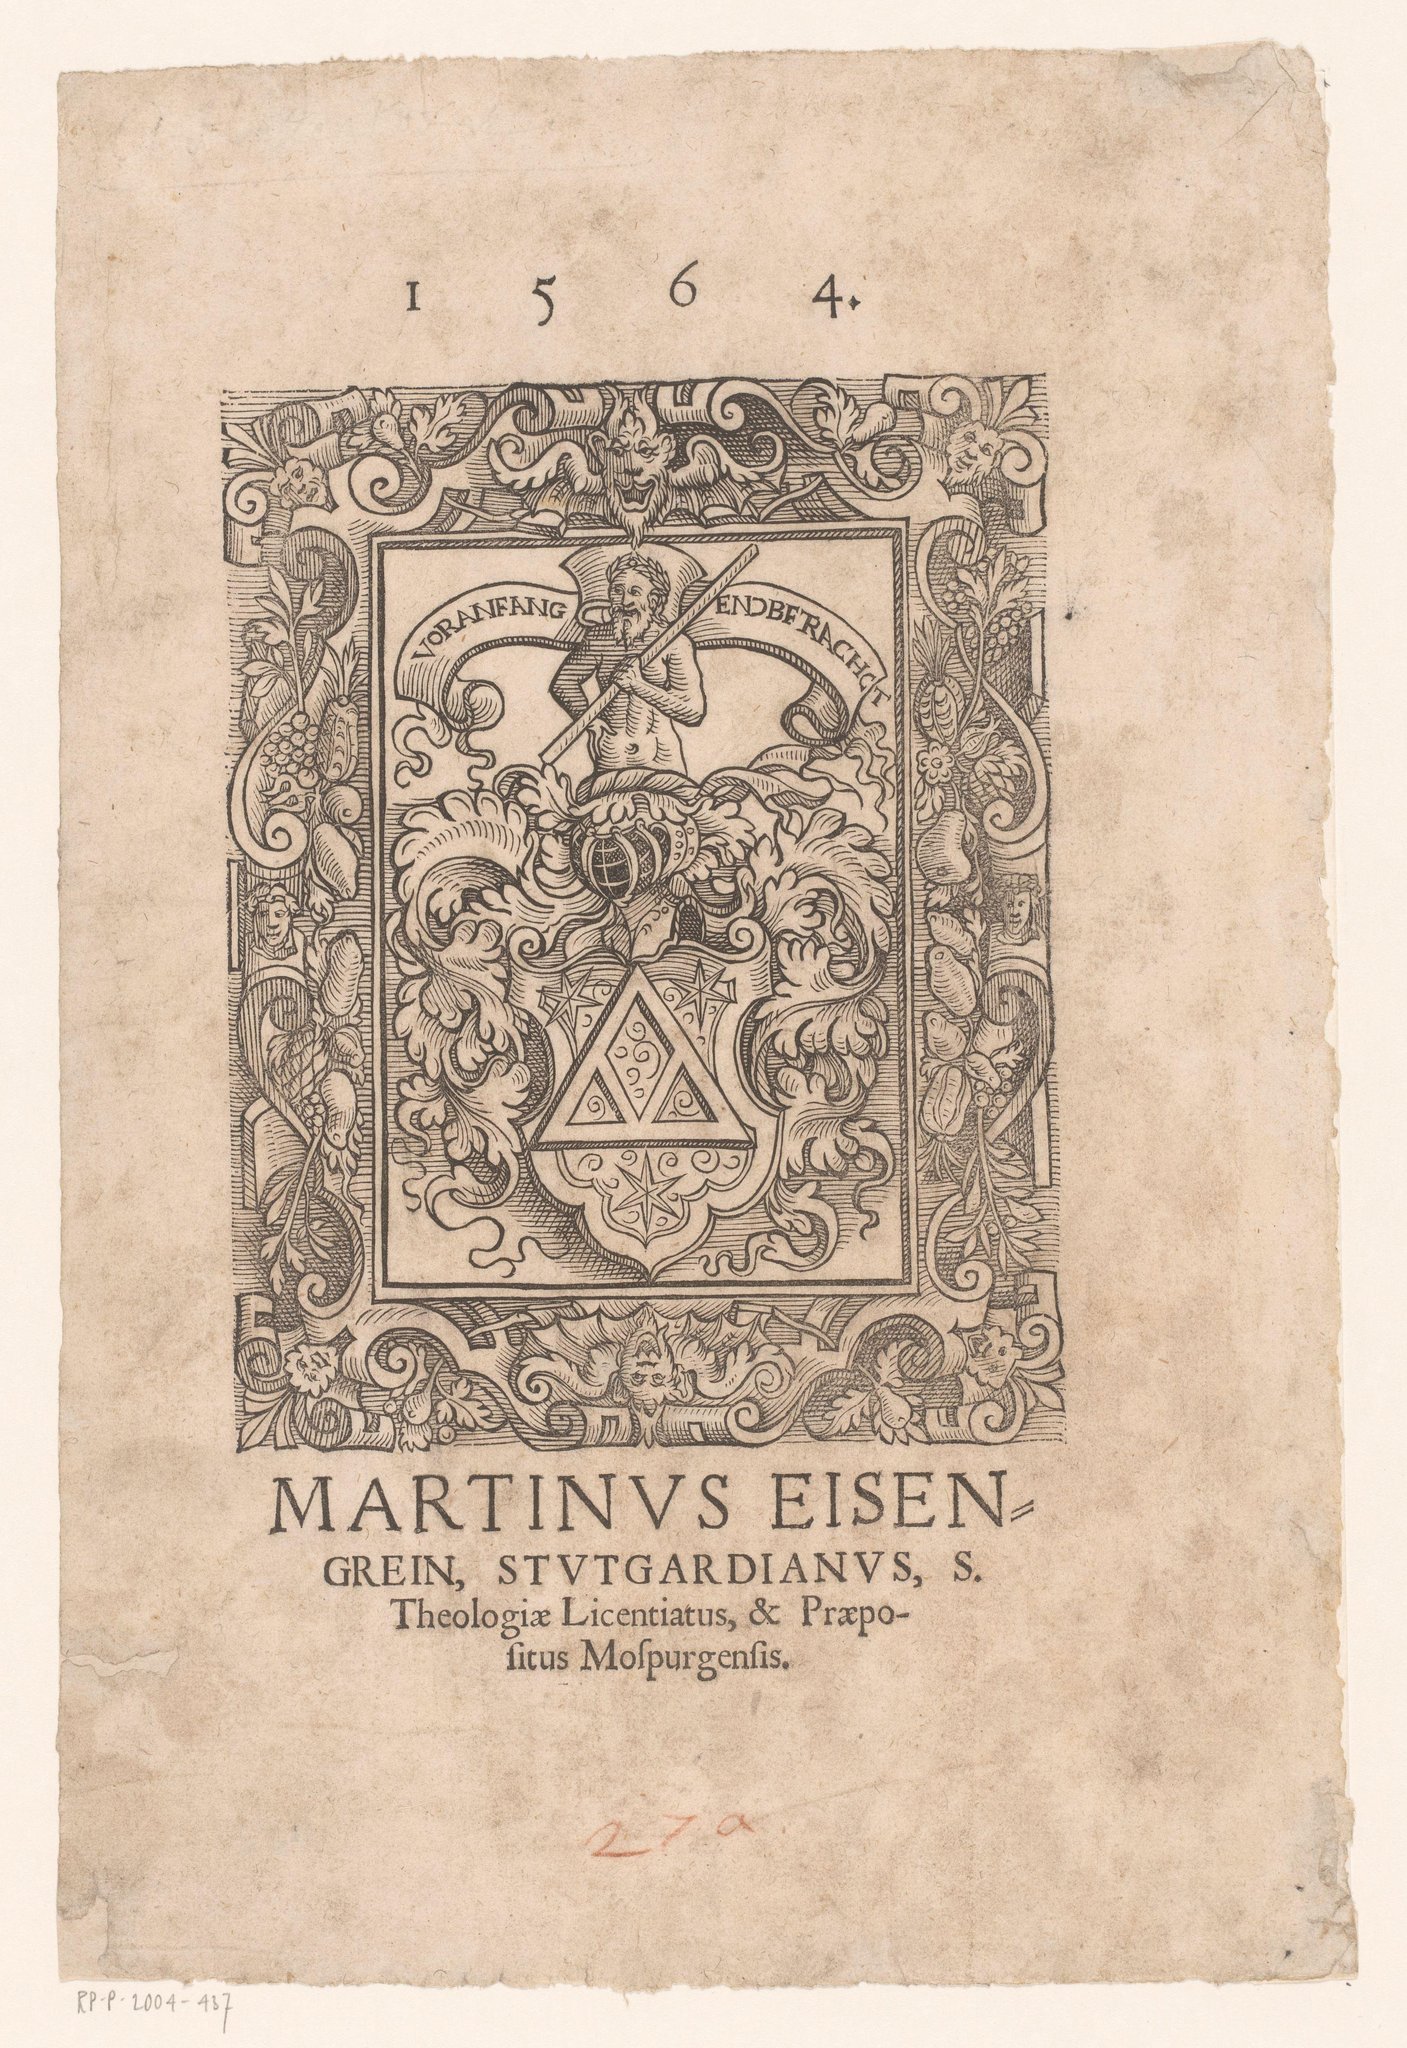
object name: print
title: Wapenschild van Martin Eisengrein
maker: Anonymous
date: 1564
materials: paper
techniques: woodcut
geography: germany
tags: armorial bearing, heraldry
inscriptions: collector's mark: Lugt 2760, collector's mark: Lugt 2228